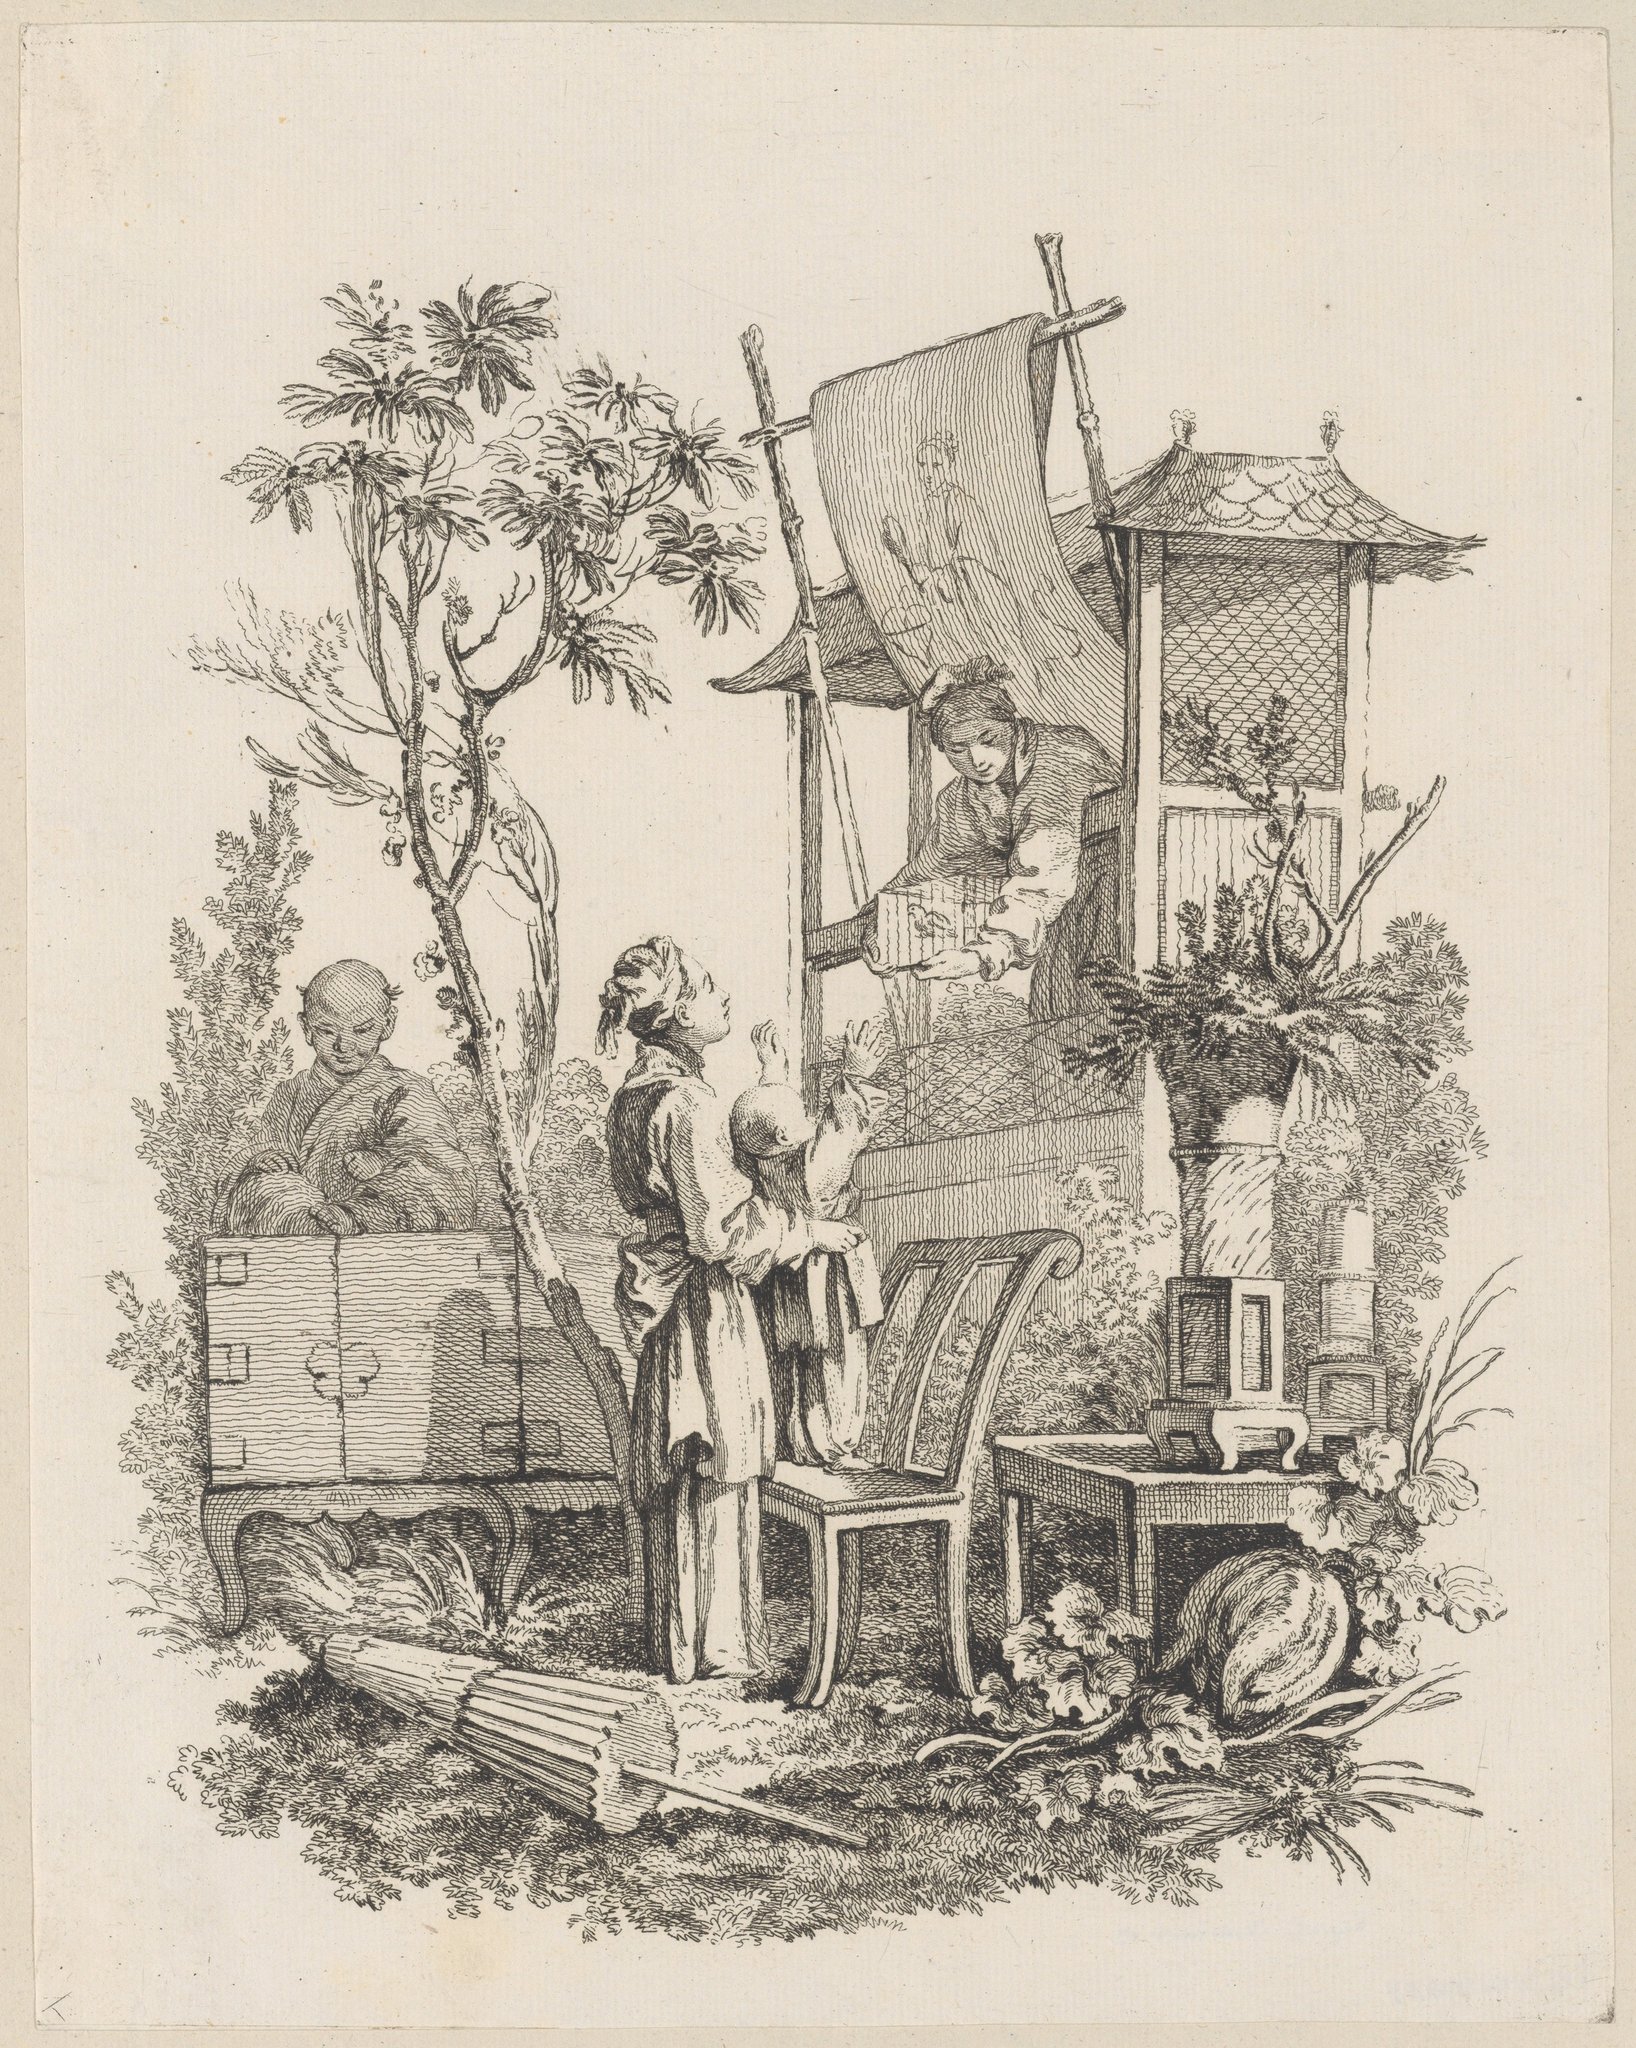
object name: print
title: Child Reaching for a Caged Bird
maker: gabriel huquier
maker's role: artist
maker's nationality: french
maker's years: 1695-1772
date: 1742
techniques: engraving, etching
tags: birds,men,women,trees